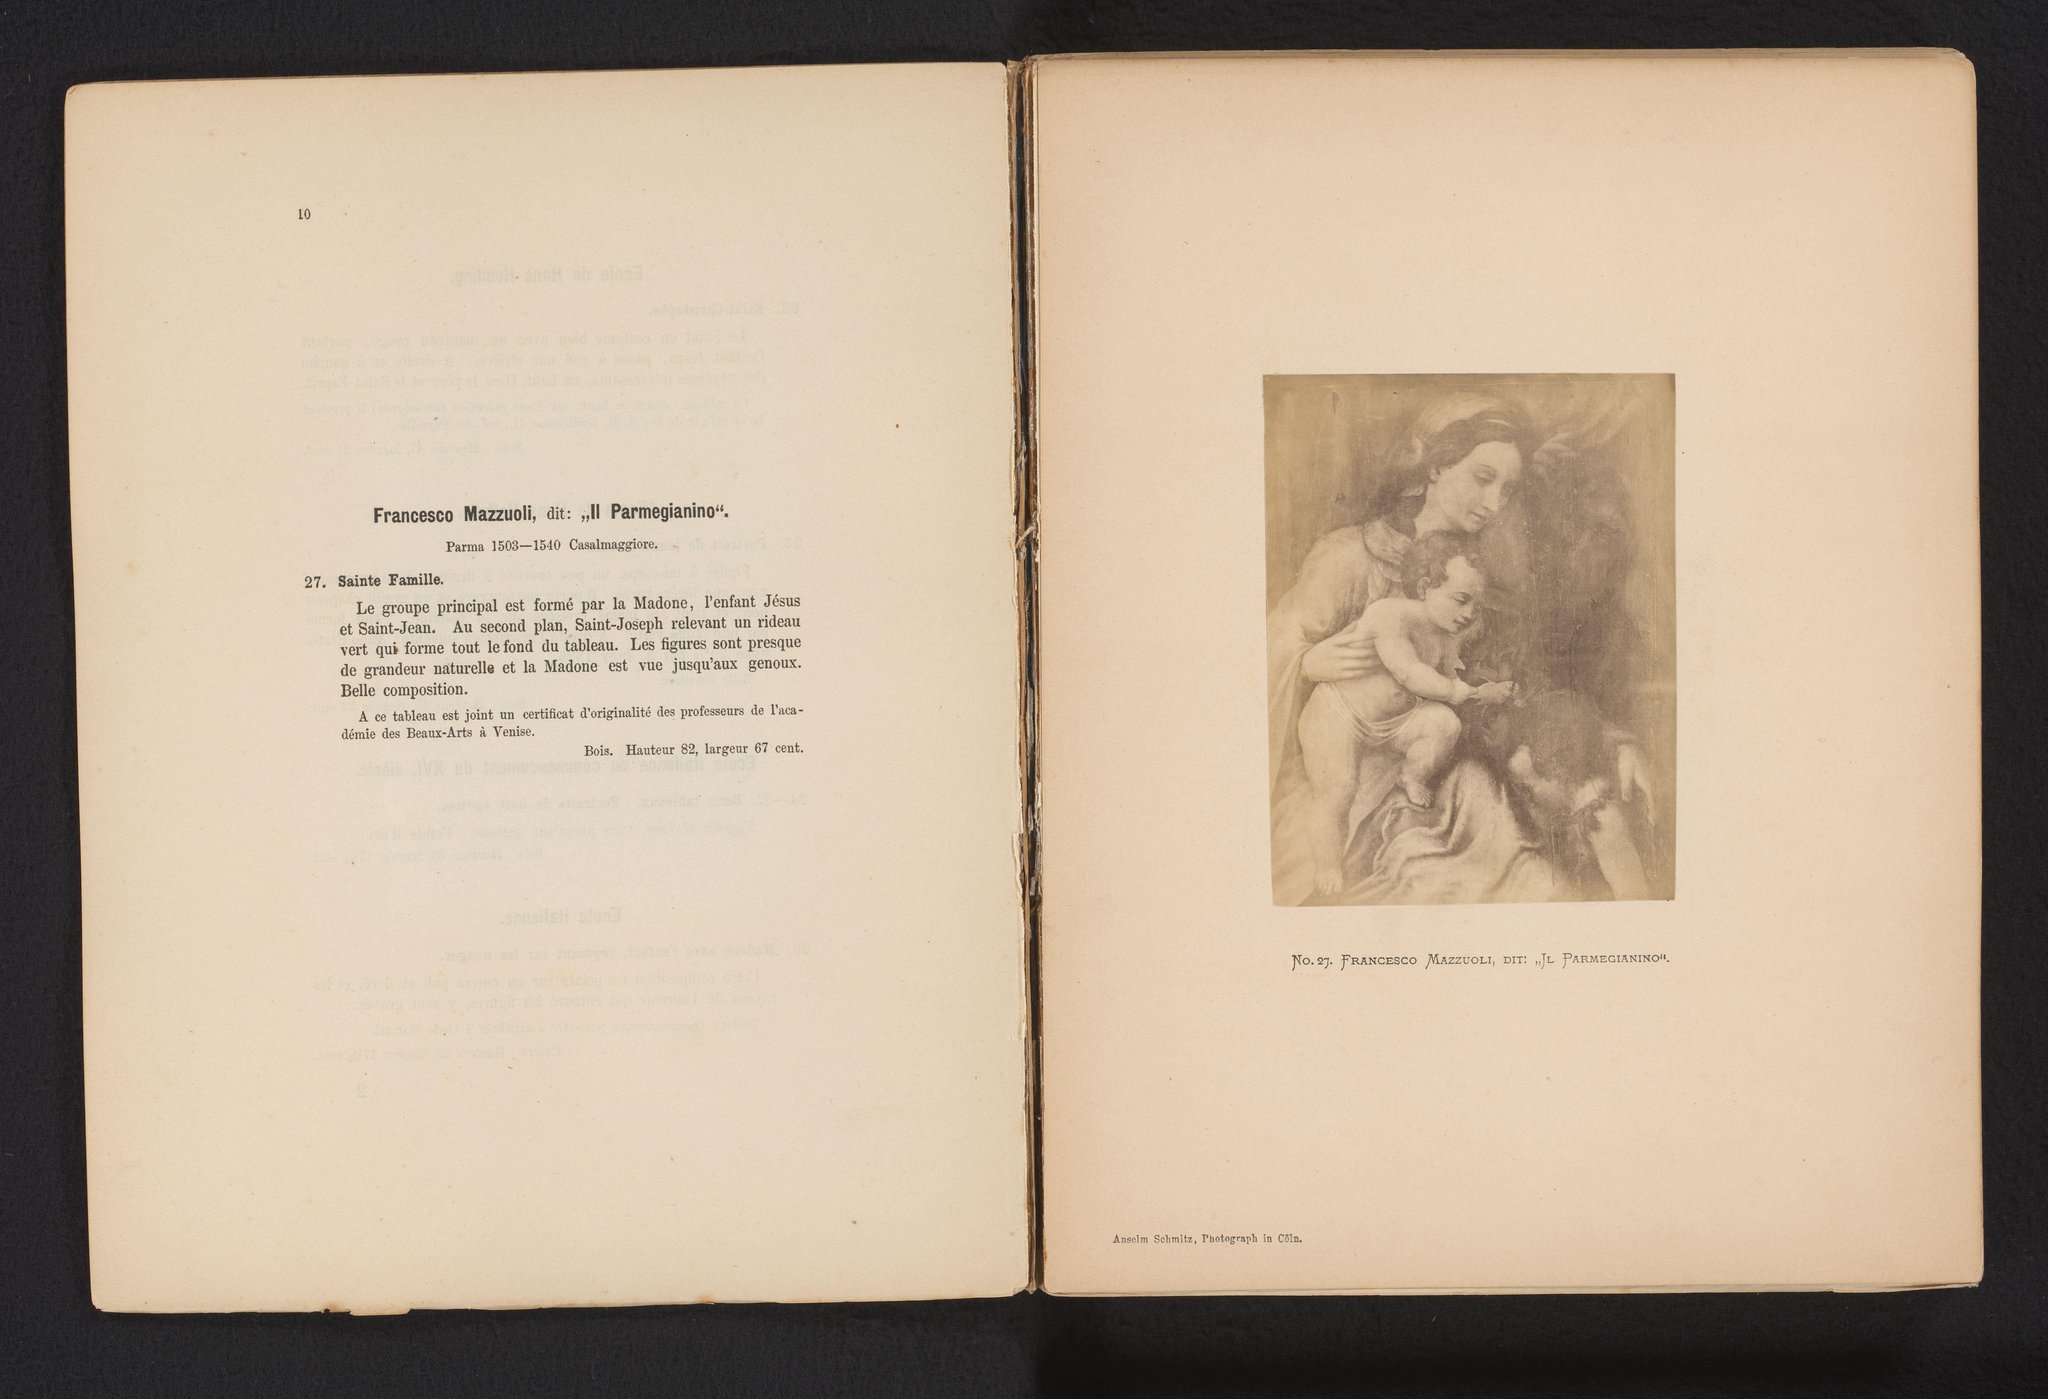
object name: photograph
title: Fotoreproductie van De Heilige Familie door Parmigianino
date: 1871-1876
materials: photographic support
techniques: albumen print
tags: saints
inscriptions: inscription: ‘No. 27. Francesco Mazzuoli, dit: "Il Parmegianino".’